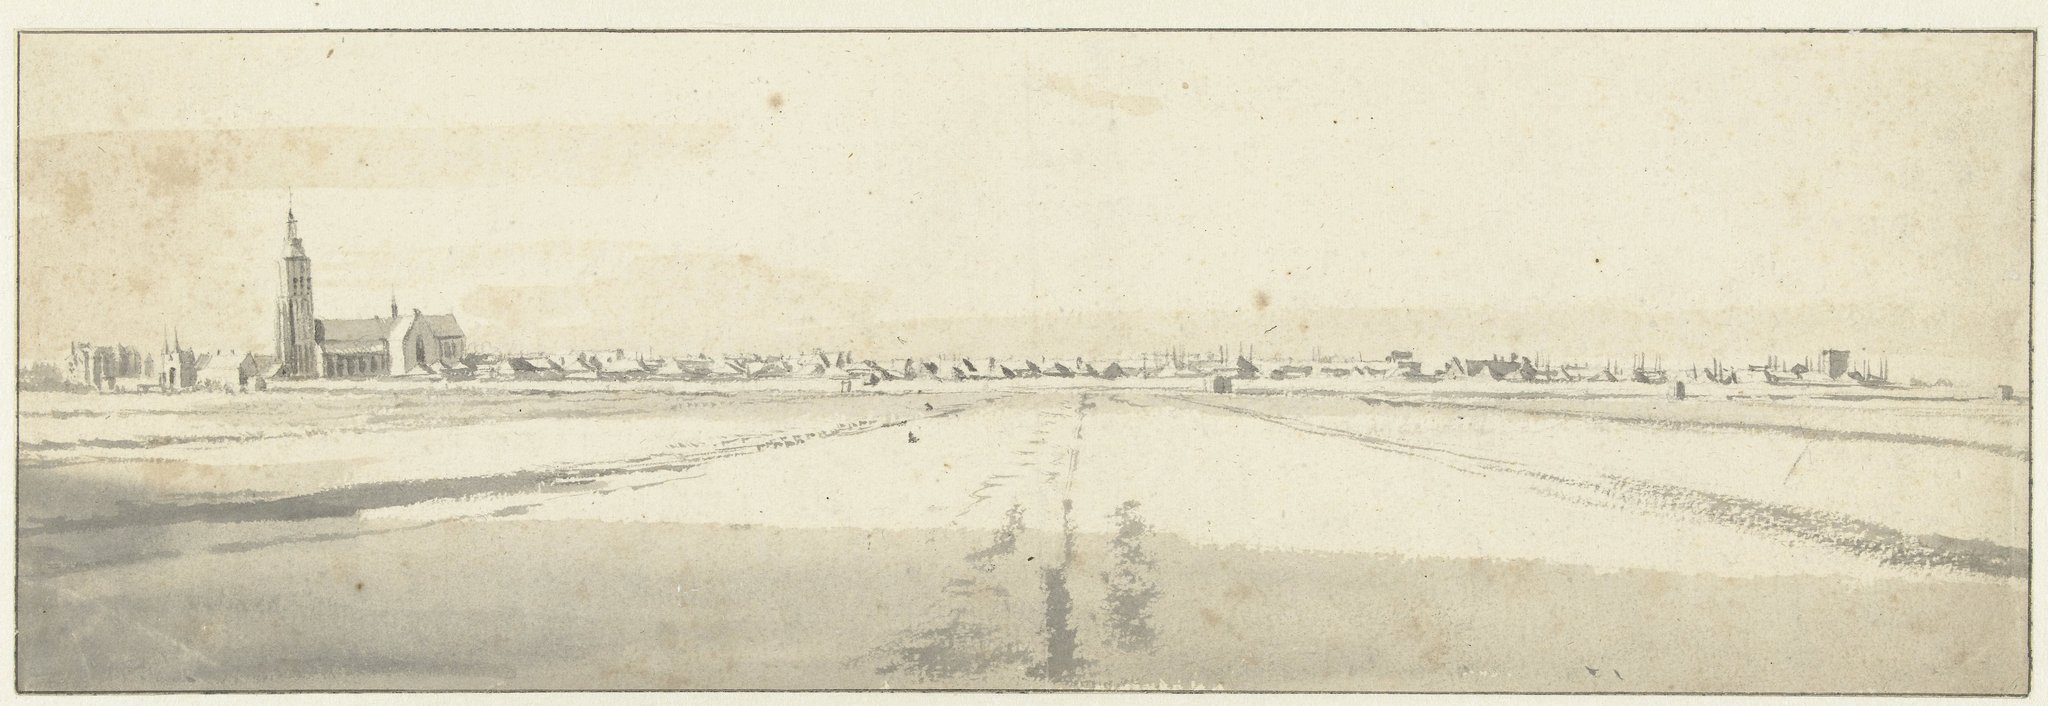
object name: drawing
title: View of Asperen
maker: roelant roghman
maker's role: draughtsman, painter, print maker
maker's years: 1627-1692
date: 1646-1647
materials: chalk, ink, paper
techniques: brush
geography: asperen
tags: prospect of city, town panorama, silhouette of city, asperen